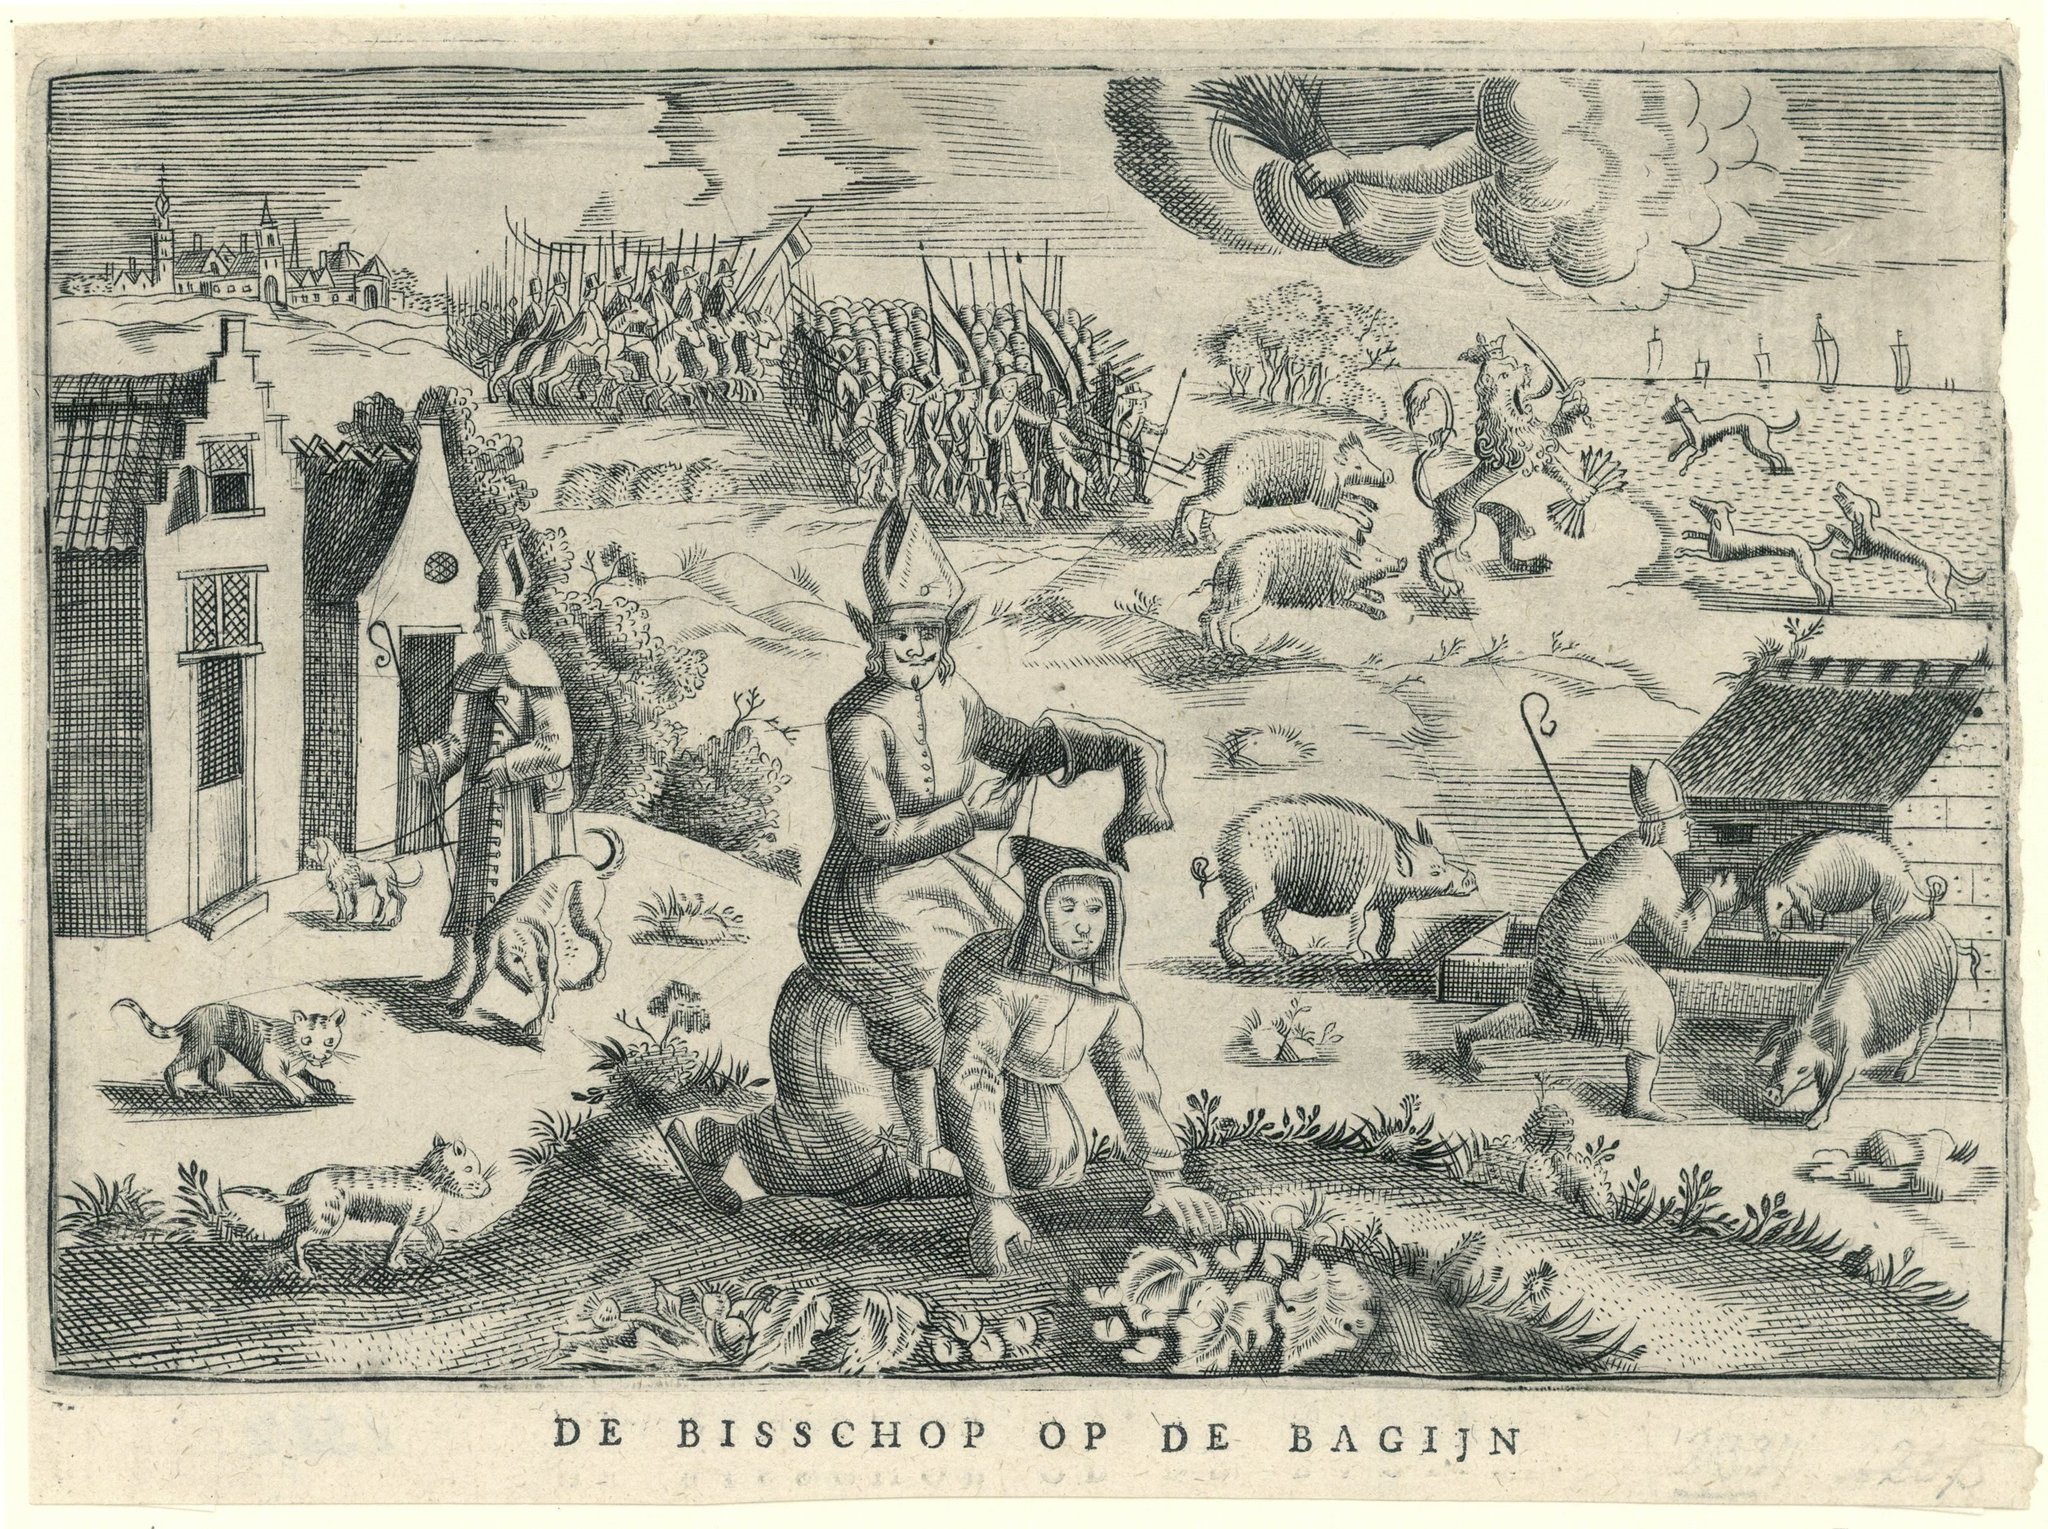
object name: cartoon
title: De Bisschop op de Bagijn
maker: Anonymous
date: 1672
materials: paper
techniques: engraving, letterpress printing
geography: northern netherlands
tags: (aspects of) christian religion or the church (as institution) ridiculed, criticized, or caricaturized, needle ~ sewing, rampjaar (disaster year)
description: Spotprent op Christoph Bernard von Galen, de bisschop van Munster, 1672. Zittend op de rug van een bagijn stopt hij een kous. Links gaat de bisschop met een hond langs huizen, rechts knielt hij als de Verloren Zoon tussen de varkens. Op de achtergrond oprukkende legers, de Hollandse Leeuw tussen de varkens (Munsterse troepen) en de honden (Engelsen), in de hemel de Gesel Gods. Bij deze prent behoort een tekstblad met vers.